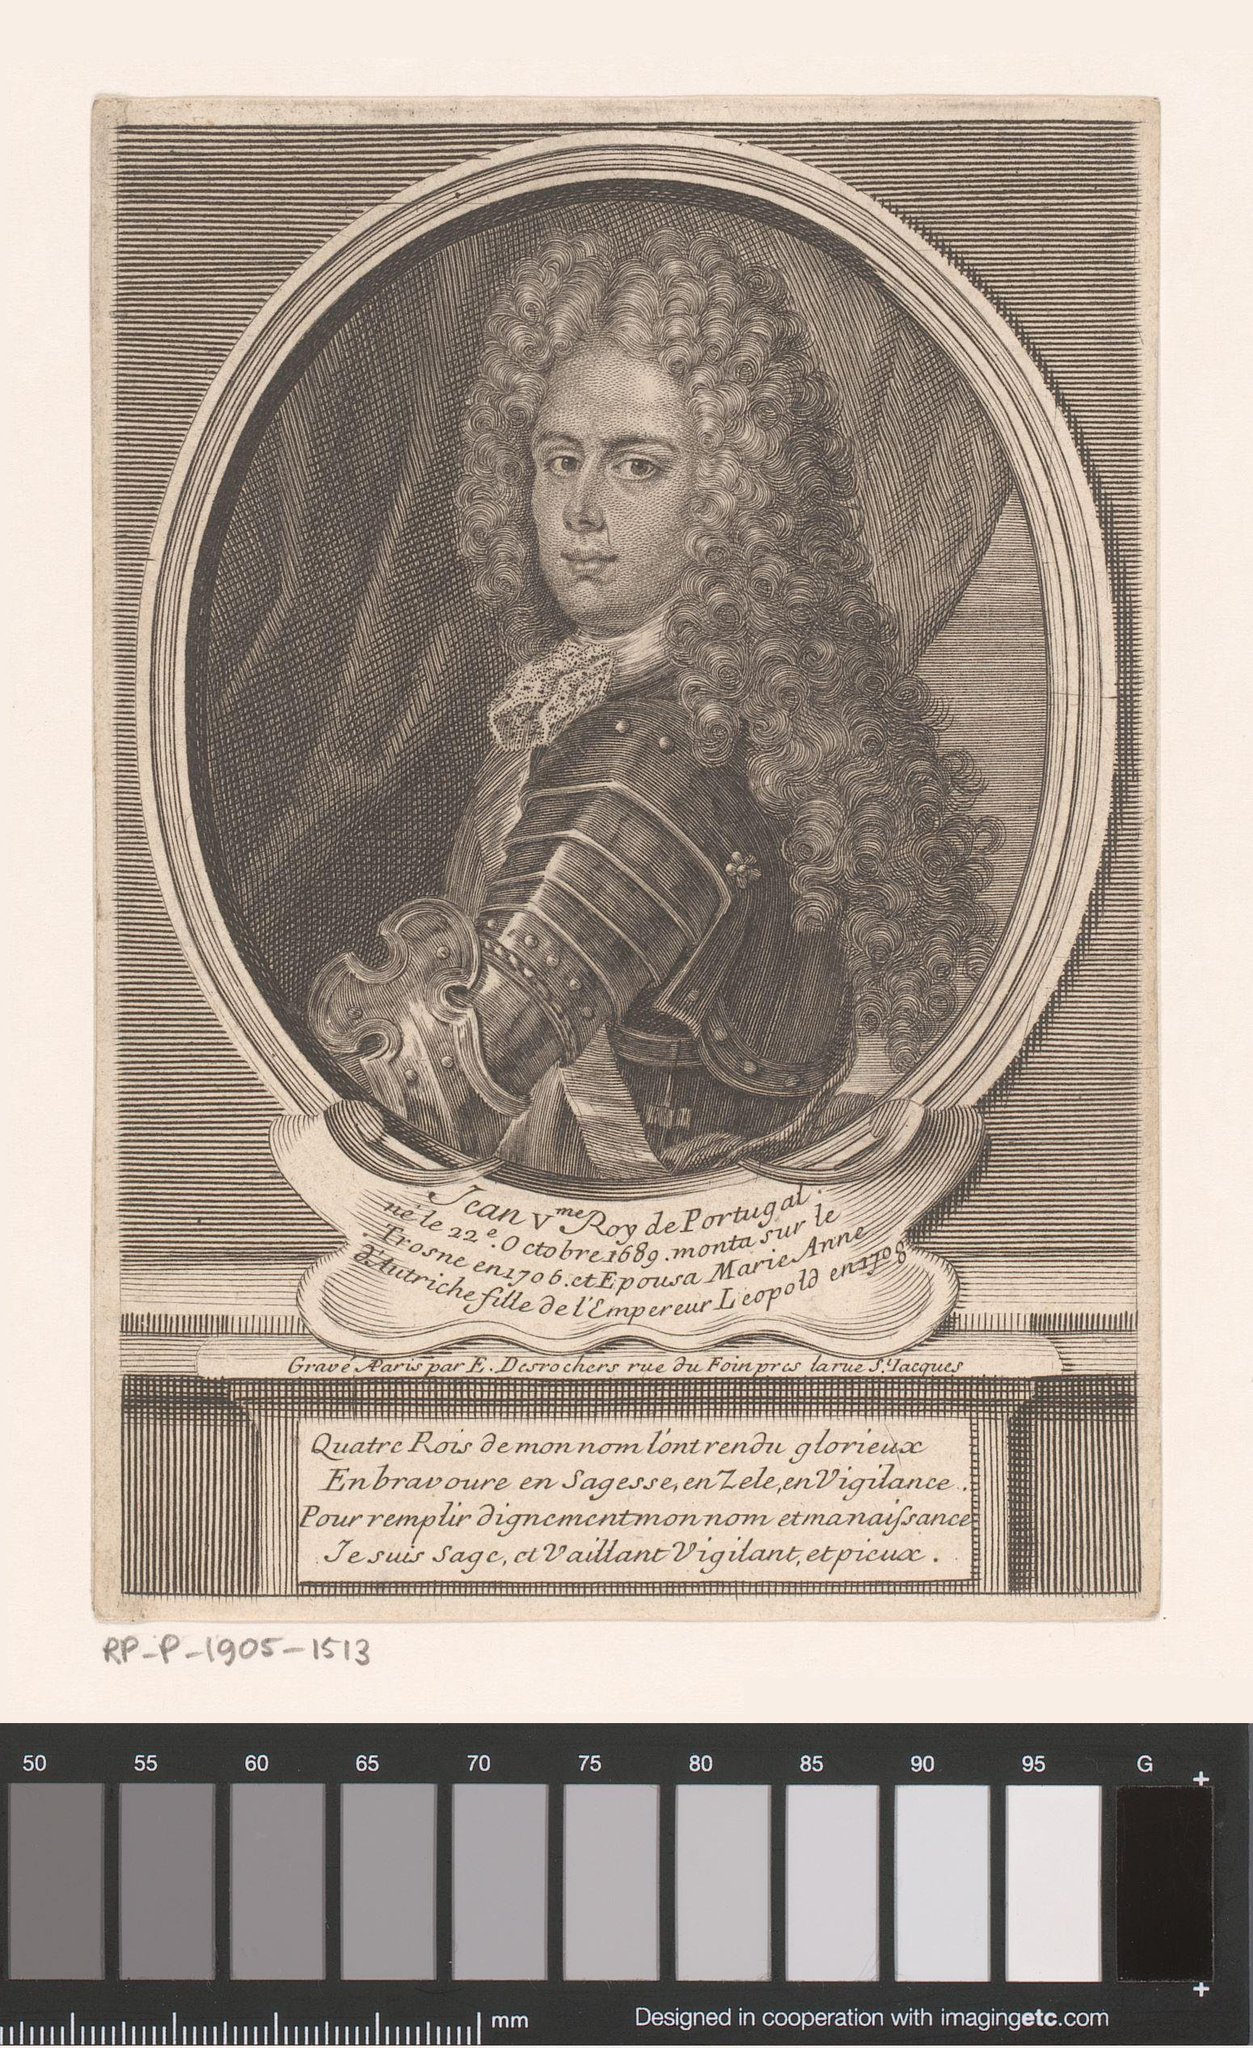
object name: print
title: Recueil de portraits (...)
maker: étienne desrochers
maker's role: print maker, publisher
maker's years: 1668-1741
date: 1726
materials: paper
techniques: engraving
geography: paris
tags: historical persons, king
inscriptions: collector's mark: Lugt 2228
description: Behoort waarschijnlijk tot een serie portretten, grotendeels door Etienne Desrochers, getiteld: 'Recueil de portraits de personnes qui se sont distinguées tant dans les Armes que dans Belles-Lettres et les Arts, comme aussi la famille royale de France et autres cours étrangères'. De serie werd initieel uitgegeven door Desrochers en aangekondigd in 'Mercure' in mei 1726, p. 985. Echter was Desrochers reeds enkele jaren eerder begonnen met het uitgeven van de serie. Na de dood van Desrochers werd de serie voortgezet door Gilles Edme Petit. Een latere staat werd uitgegeven door Jean François Daumont in Parijs.